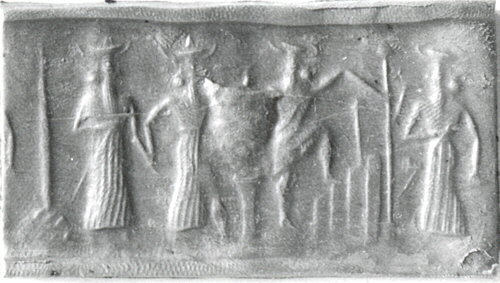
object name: cylinder seal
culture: akkadian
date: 2350-2150 BCE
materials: limestone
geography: mesopotamia